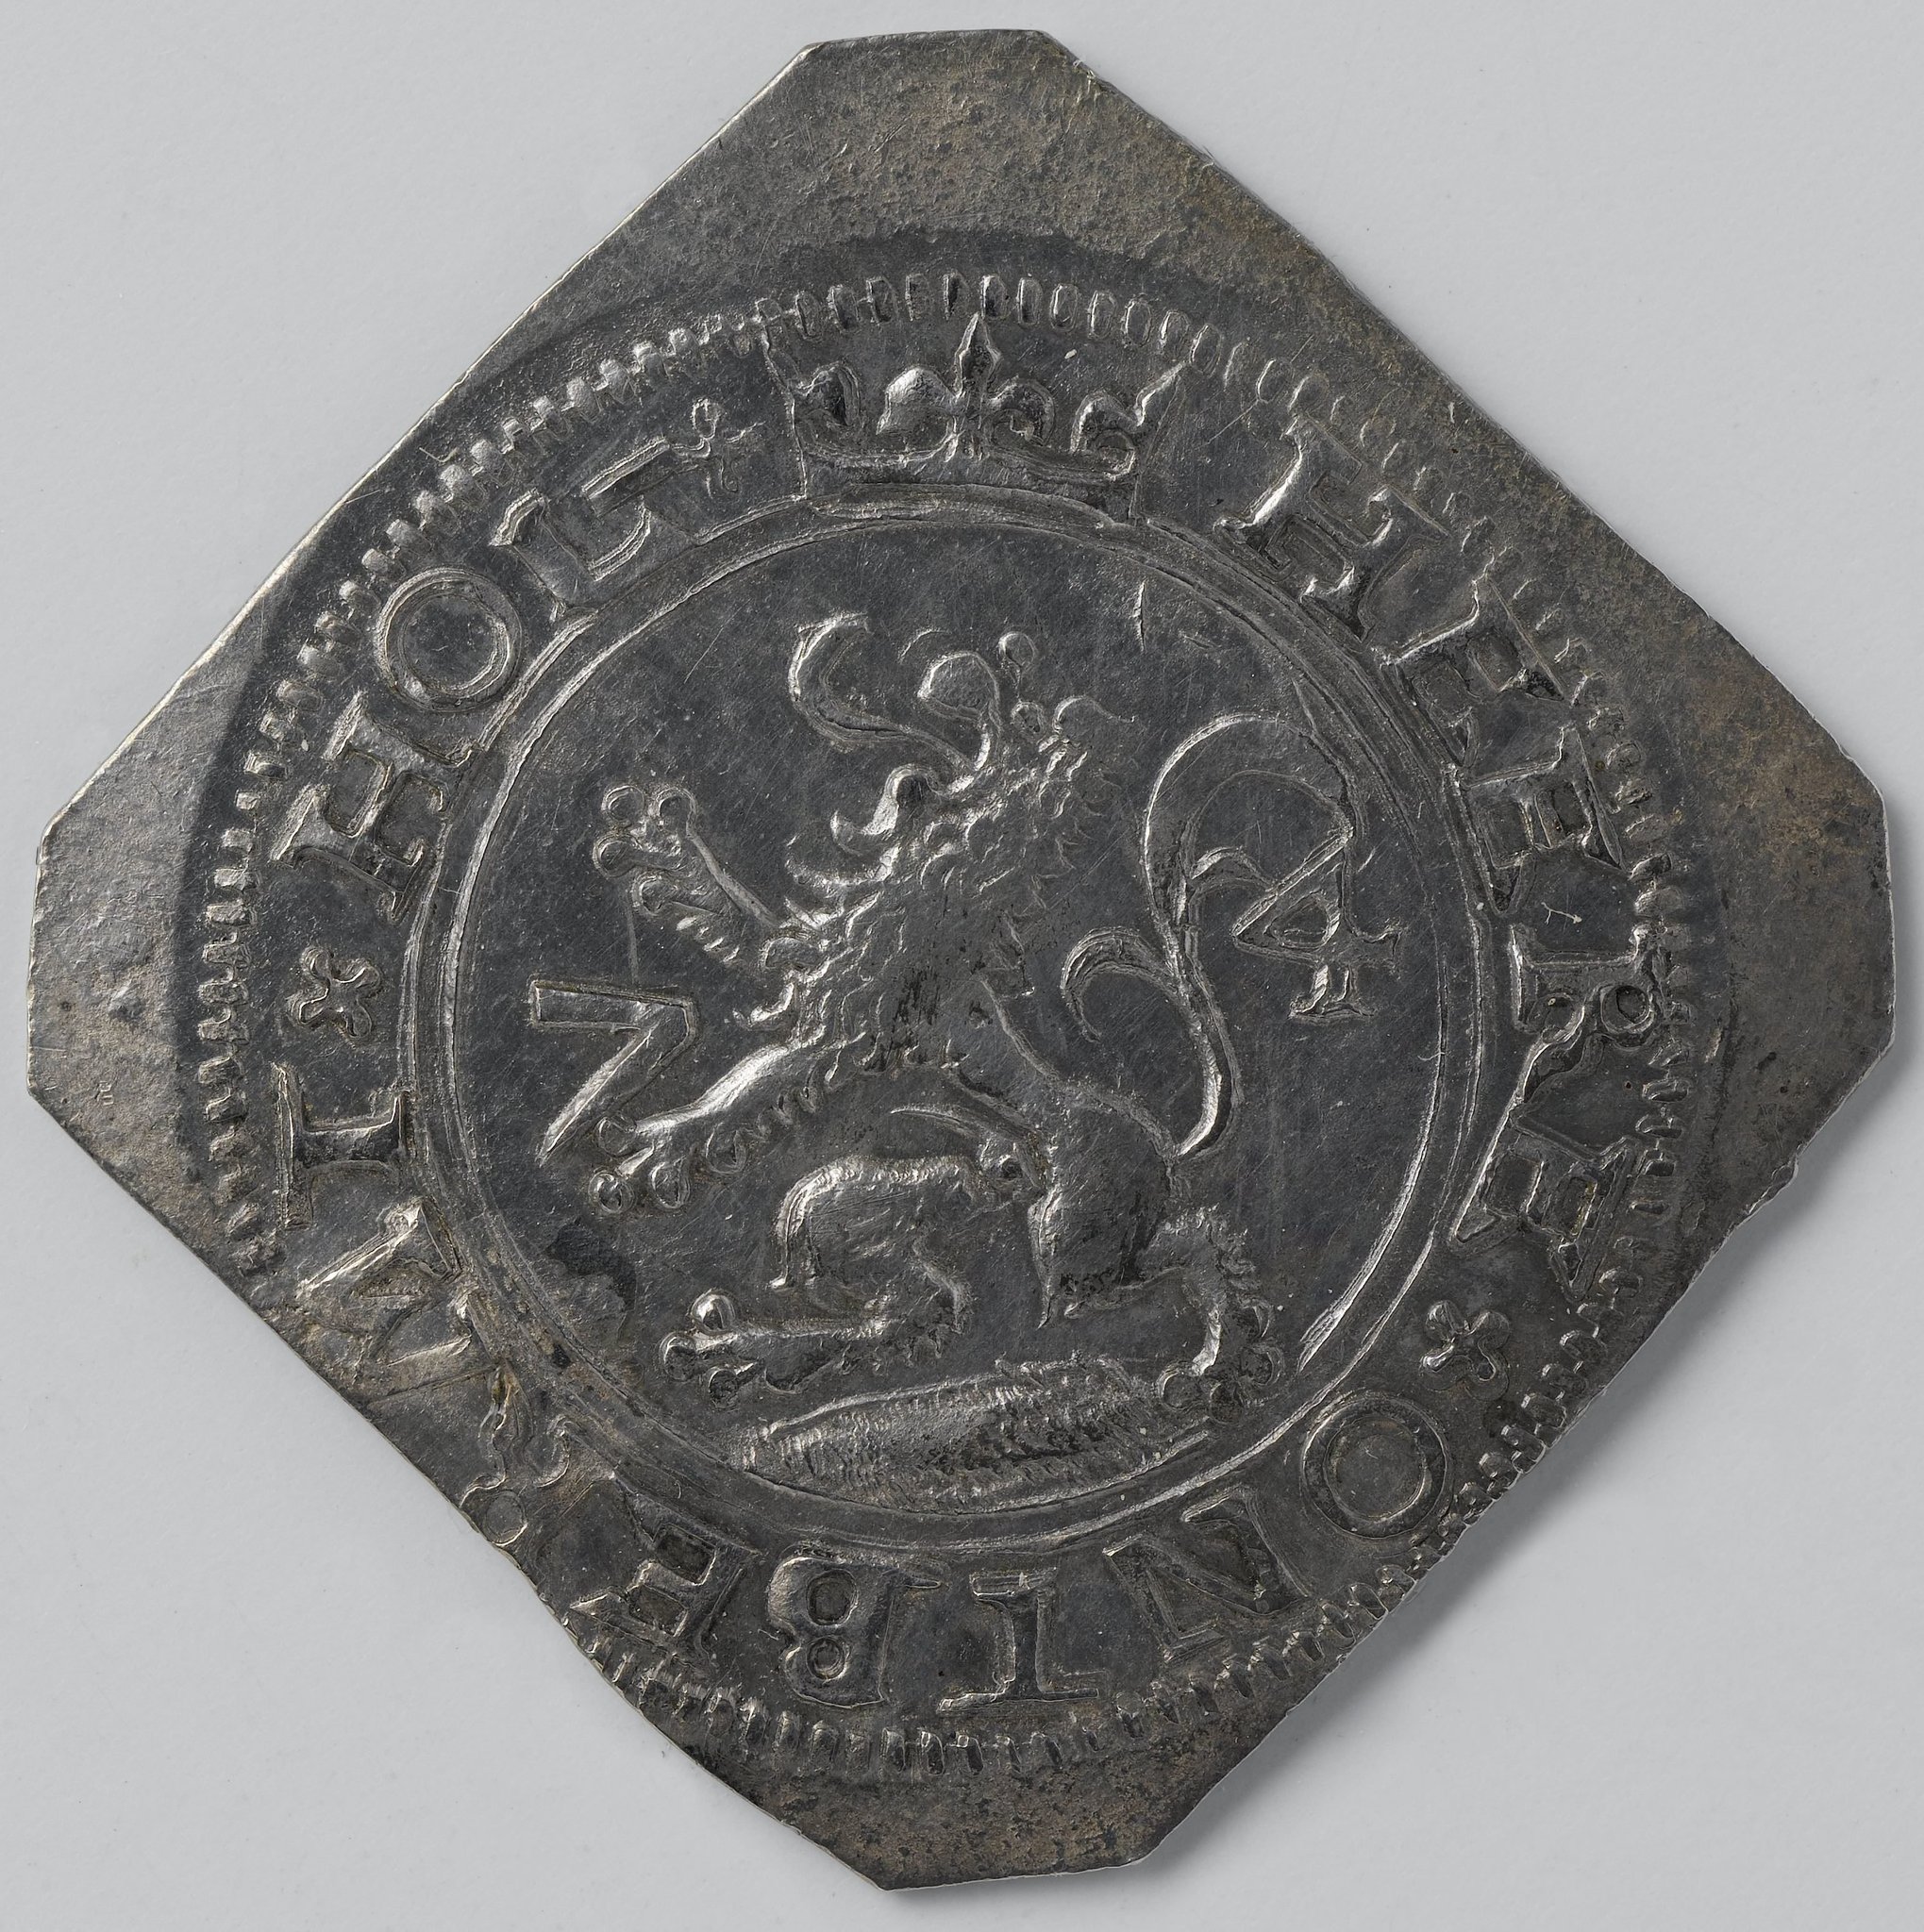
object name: halve stuiver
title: Halve stuiver, noodmunt uit Leiden, waartegen de papieren noodmunten uit de eerste fase van het beleg ingewisseld konden worden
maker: Anonymous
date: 1574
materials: silver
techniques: striking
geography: dordrecht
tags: leiden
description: Siege coins from Leiden, 1574. When towns were besieged for long periods money would often become scarce. In order to pay the soldiers who defended the town, for example, special coins were minted. When there was no more gold or silver, copper and tin were used. Coins were even made of pieces of layered paper. One of these paper coins from Leiden bears the motto: Haec Libertatis Ergo, 'this (is endured) for freedom'.